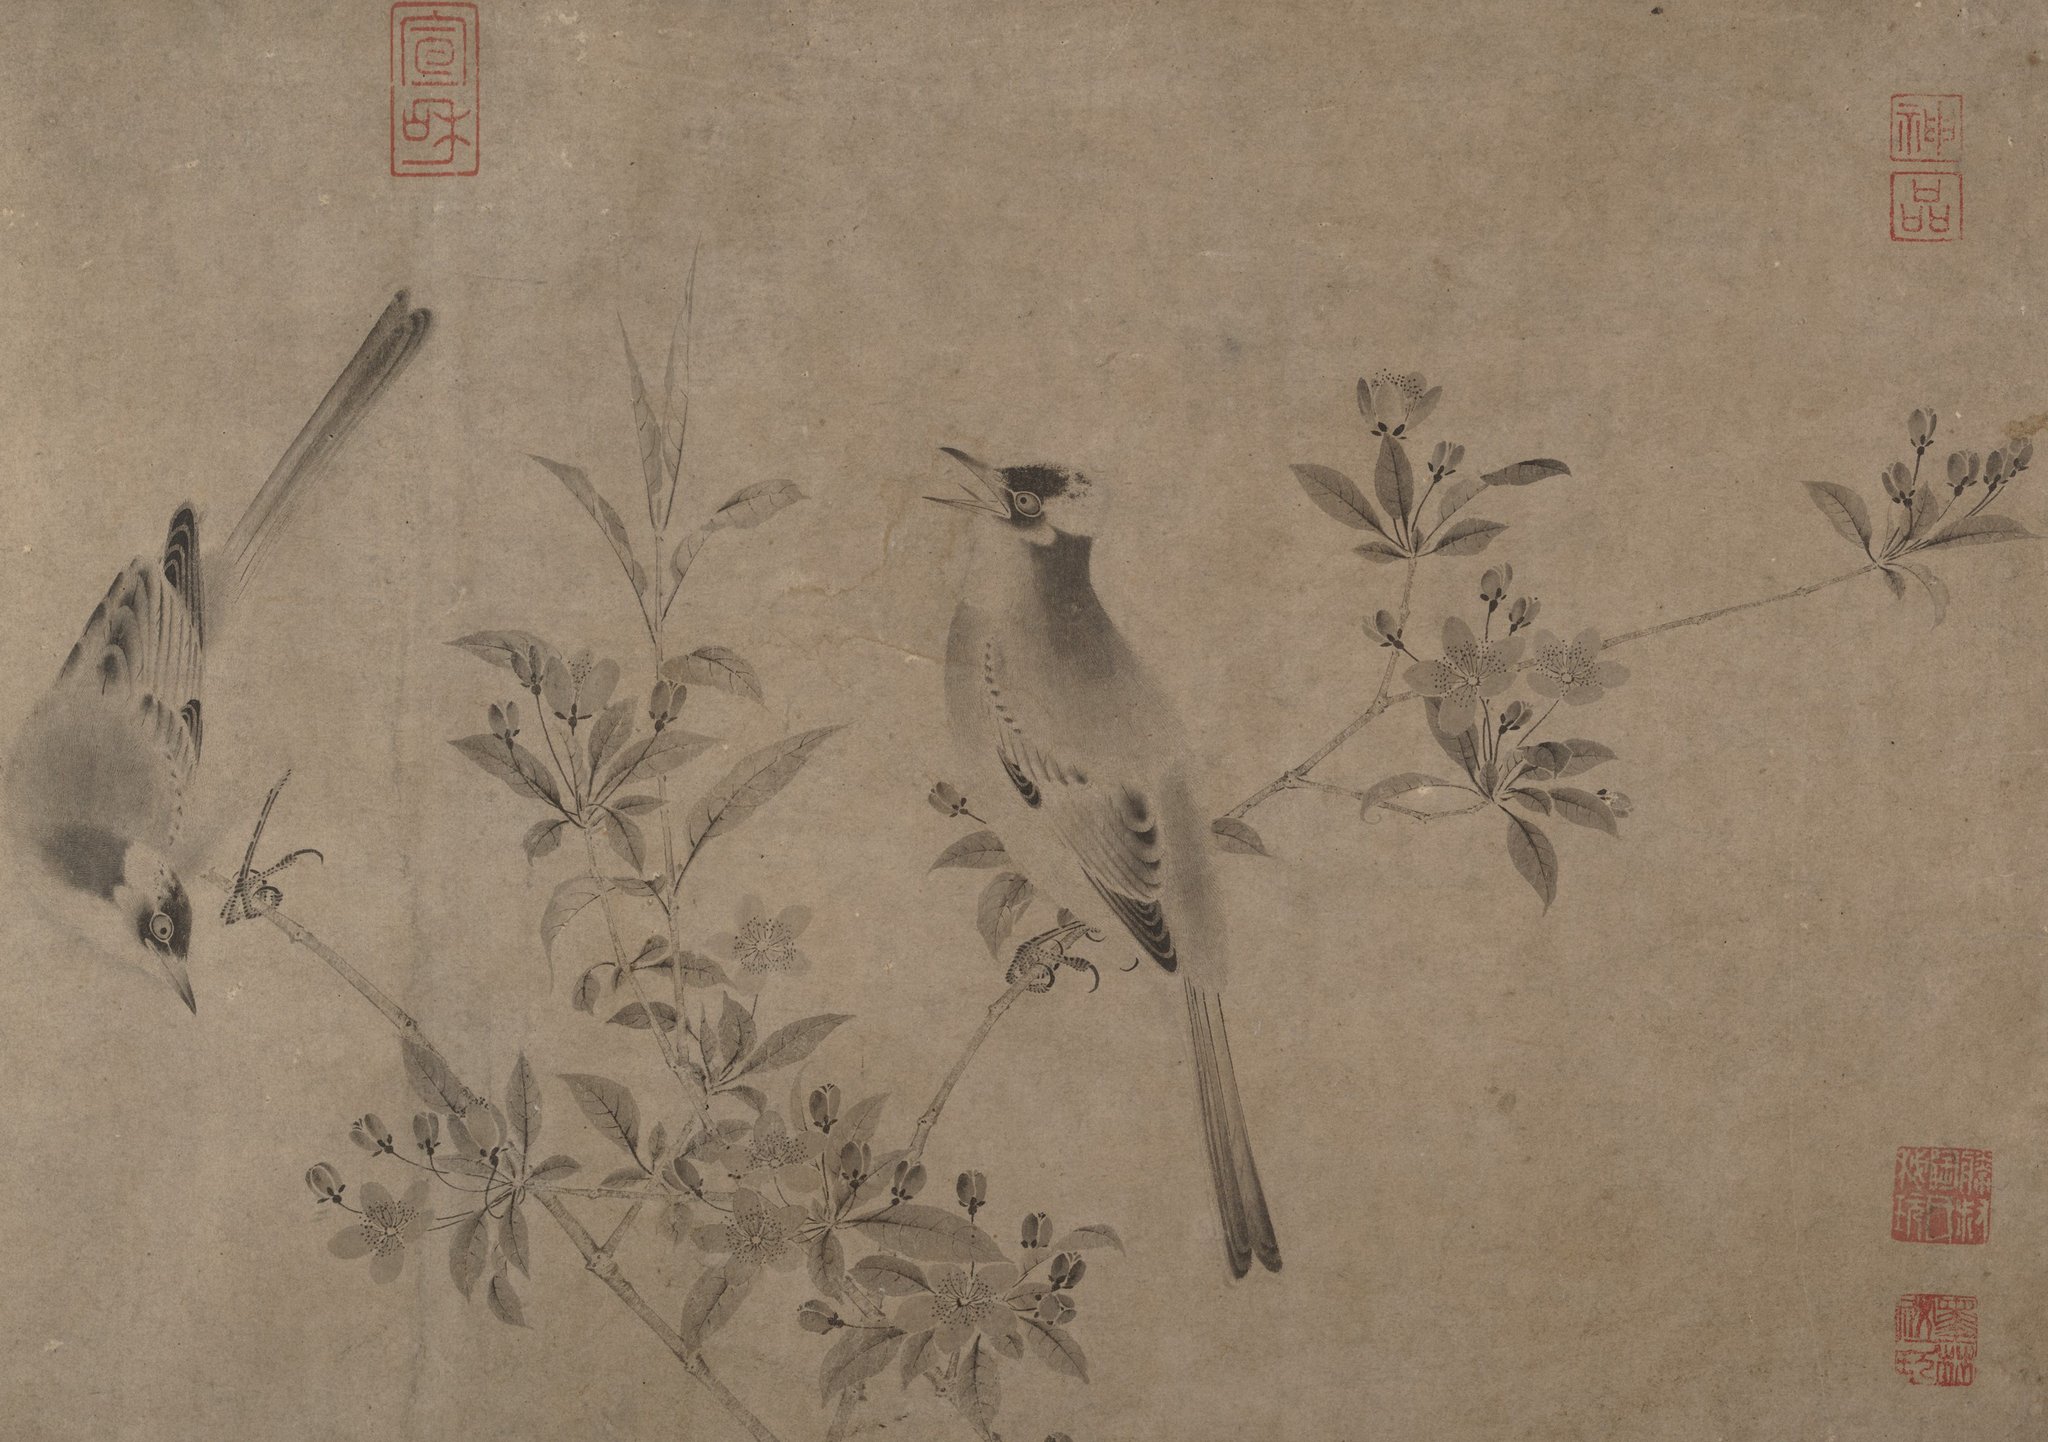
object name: handscroll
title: Chinese bulbuls on flowering crab apple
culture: chinese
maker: unidentified artist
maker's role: artist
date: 1301-1400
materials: ink, paper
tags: birds